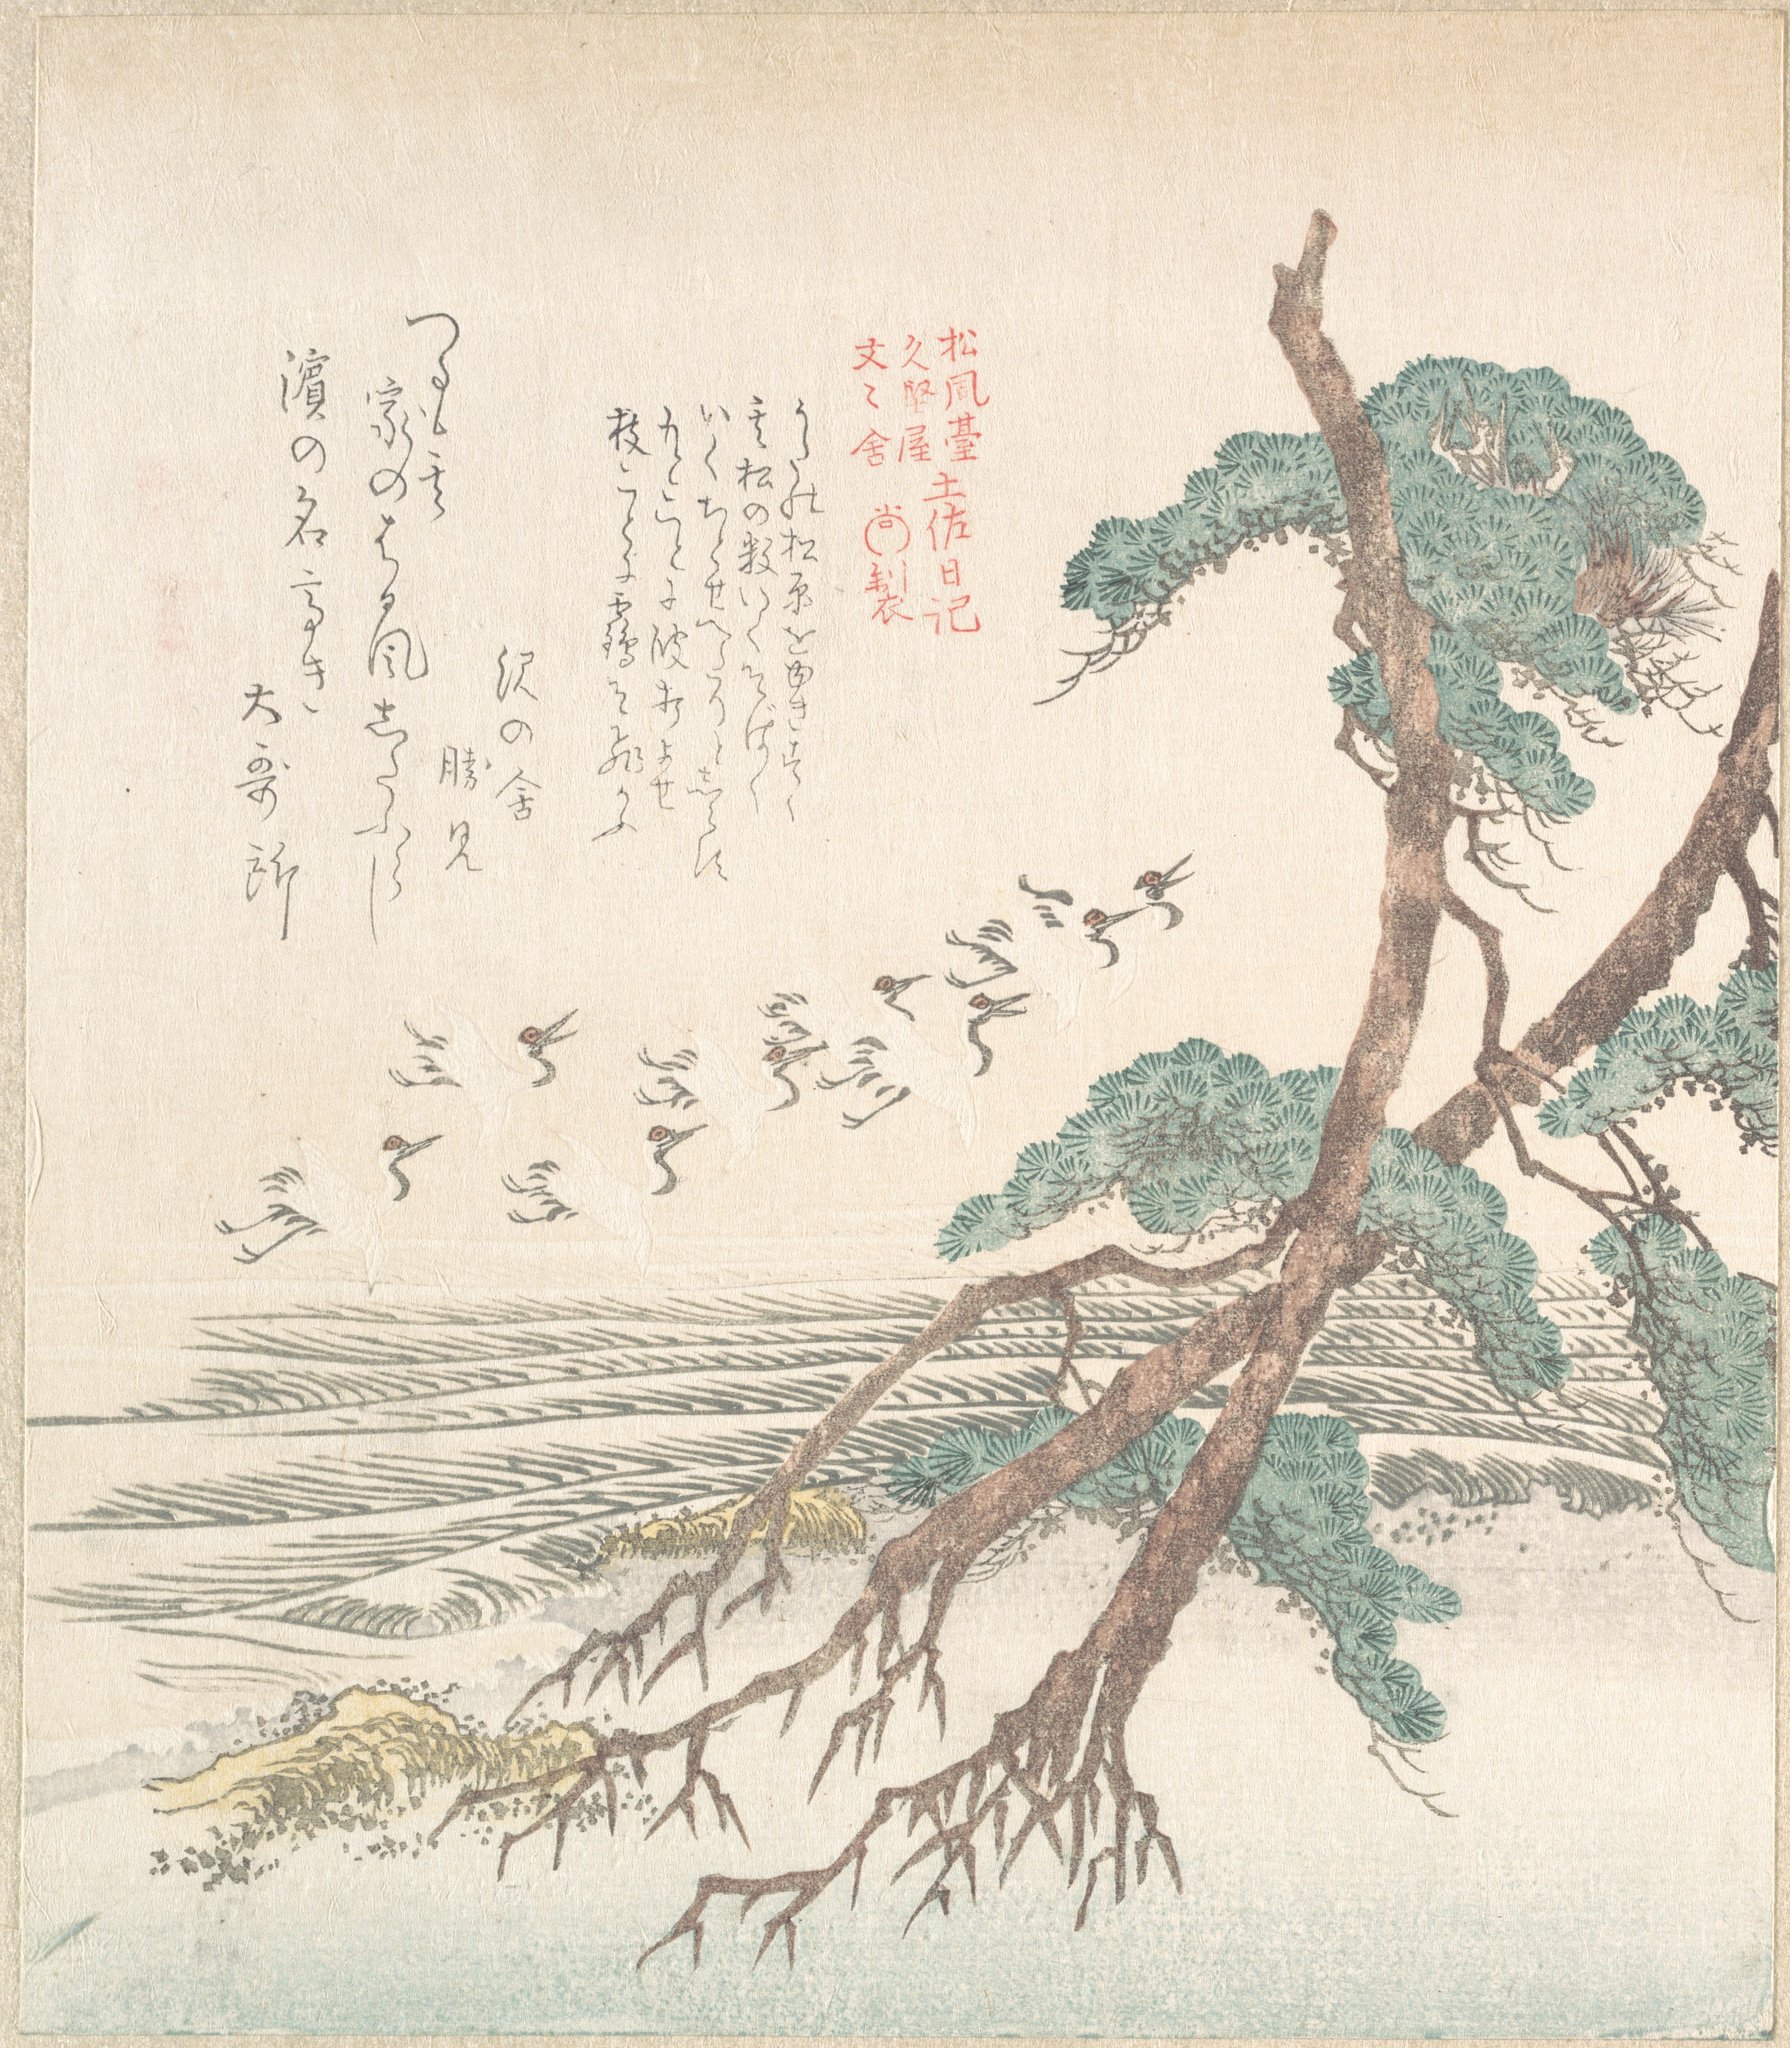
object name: print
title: Sea-Side Landscape with Pine Trees and Flying Cranes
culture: japanese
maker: kubo shunman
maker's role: artist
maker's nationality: japanese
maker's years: 1757-1820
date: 1801-1900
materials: ink, paper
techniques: surimono, woodblock print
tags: cranes,landscapes,trees